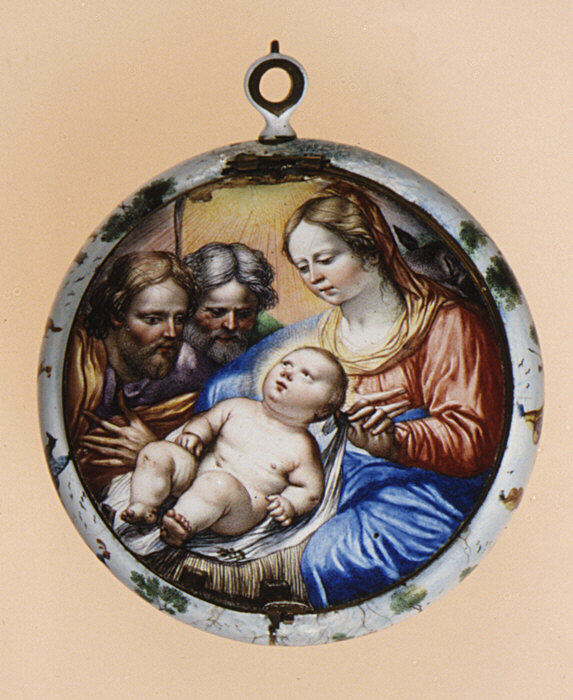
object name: watch case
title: The Nativity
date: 1650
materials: enamel, gold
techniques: painting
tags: virgin mary,jesus,nativity